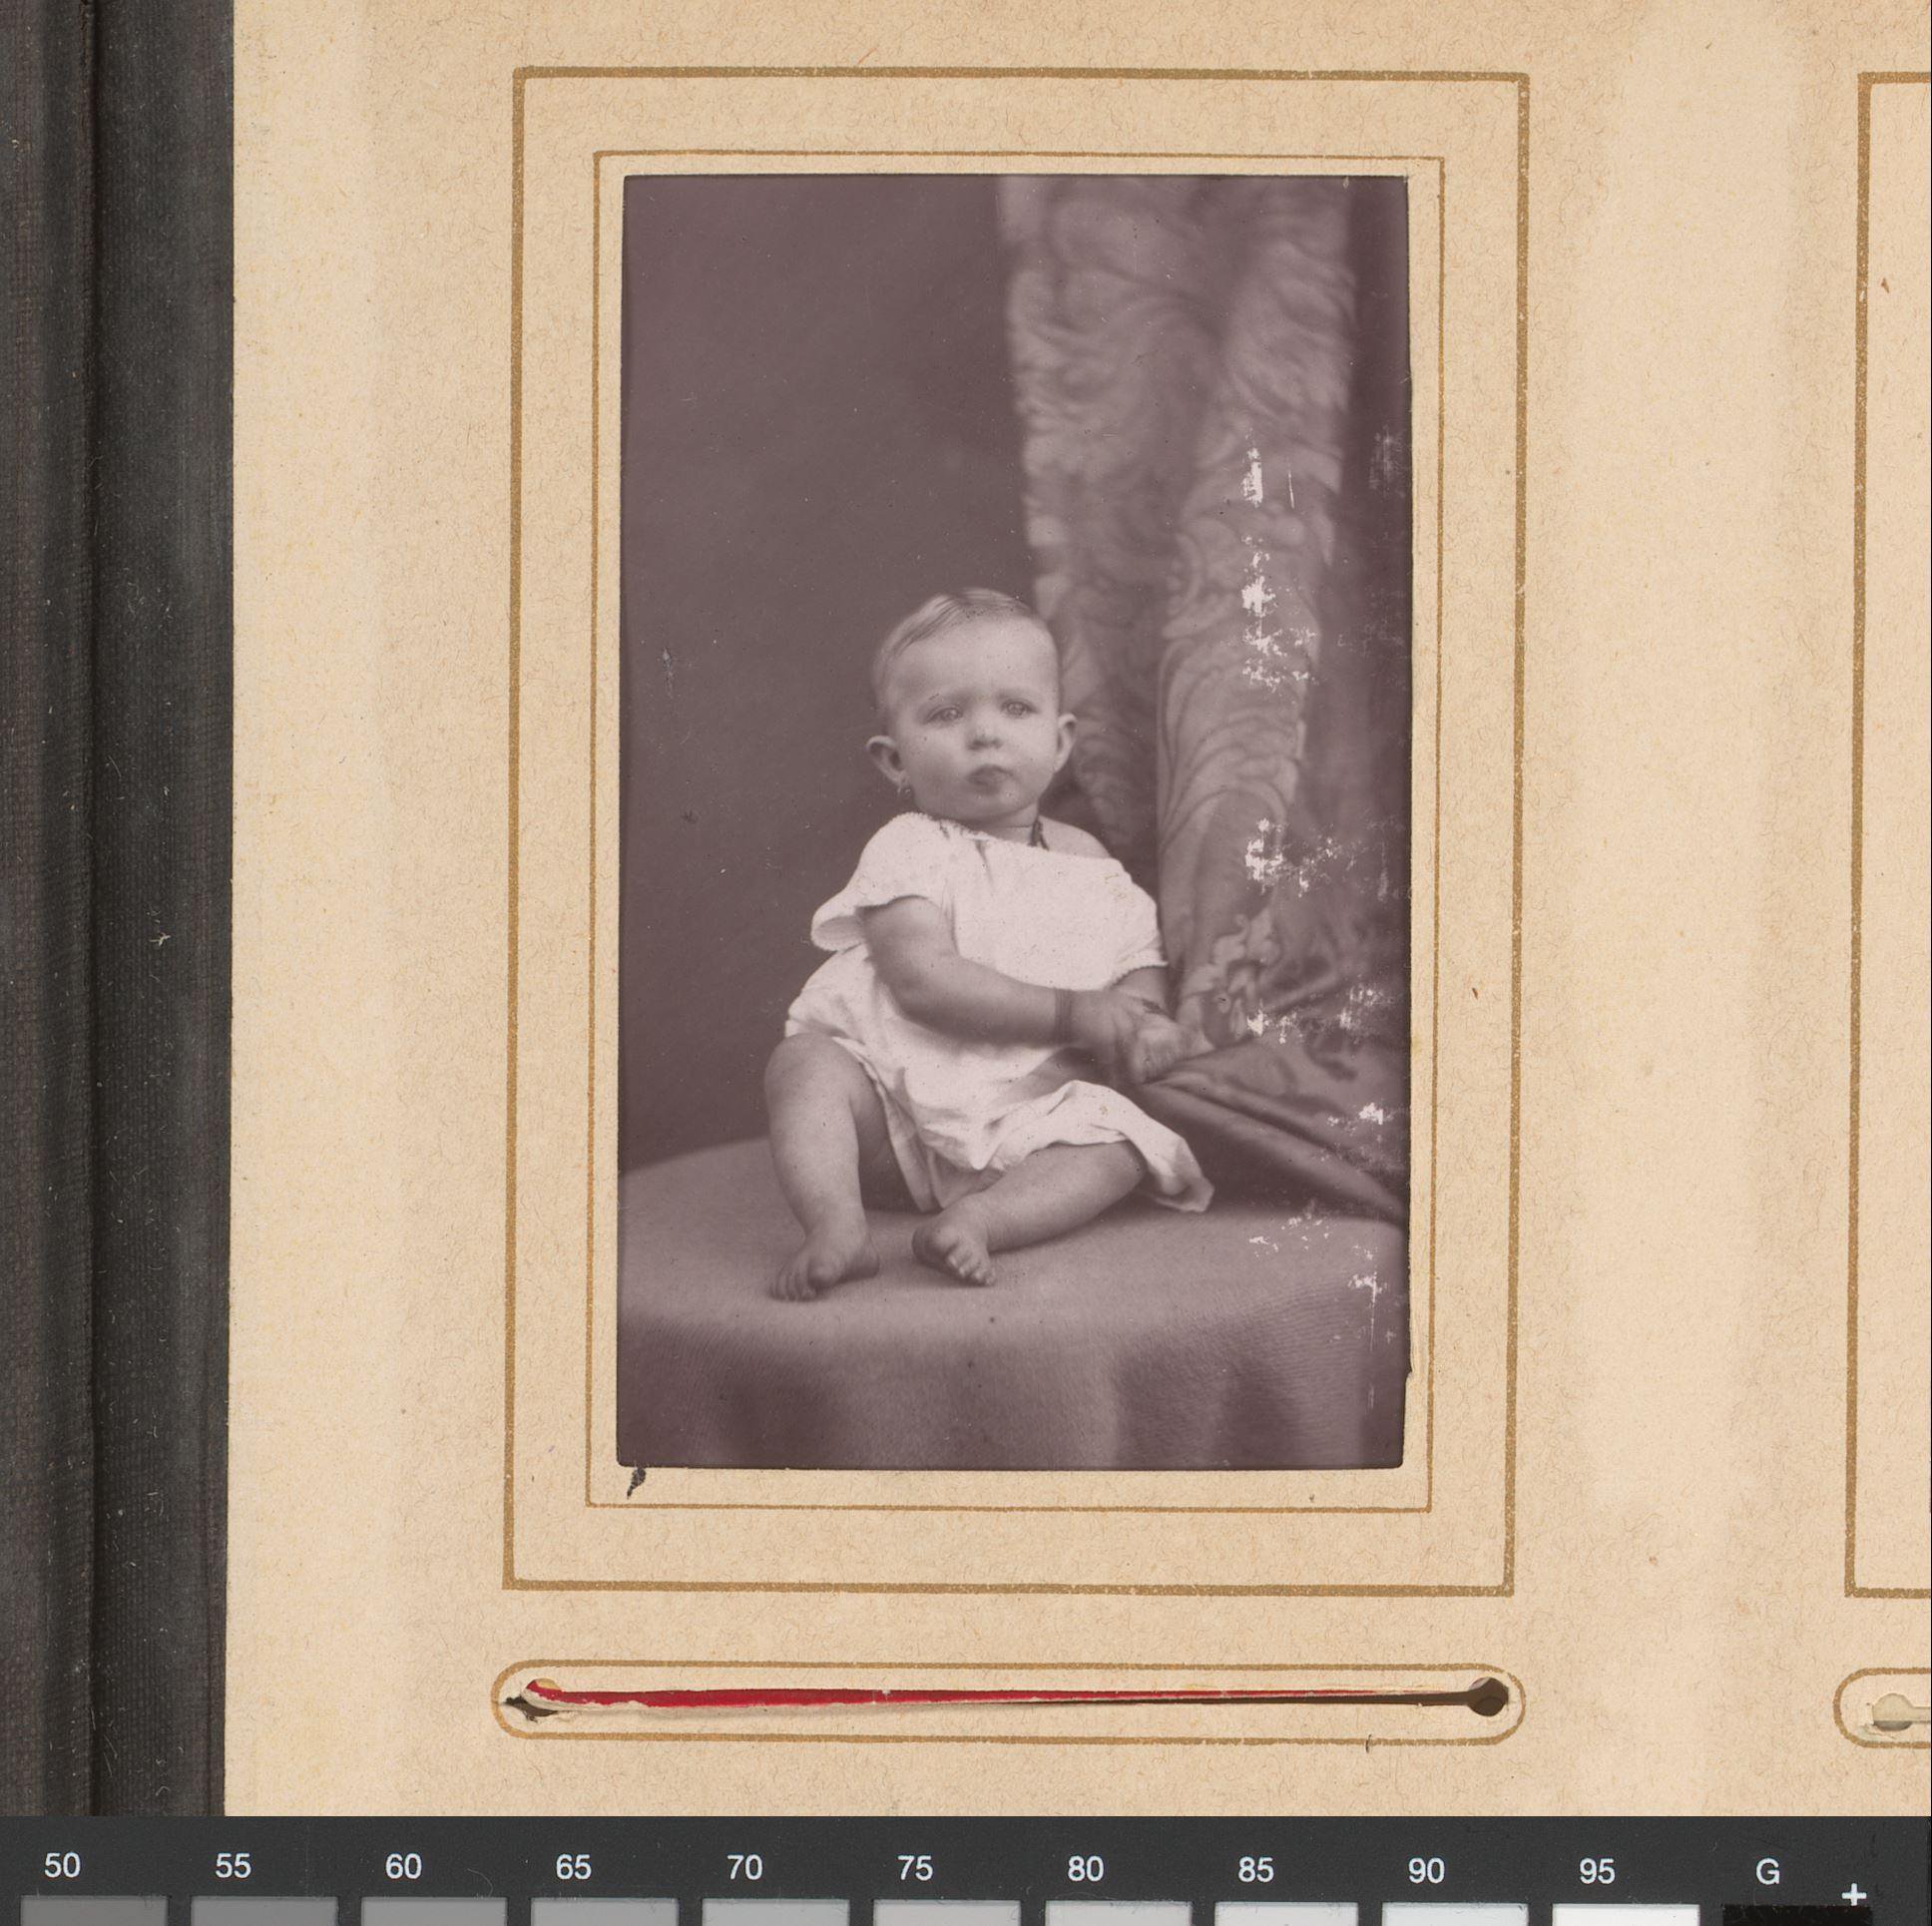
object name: carte de visite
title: Portret van een baby, aangeduid als Brigite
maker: charles emmanuel dhoy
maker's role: fotograaf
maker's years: 1823-1892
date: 1878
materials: cardboard, photographic support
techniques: collodion silver print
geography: ghent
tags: infant, baby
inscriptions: inscription: ‘Gand/ Charles d'Hoy/ Photographe/ Rue Courte du Jour 25/ près pont Madou/ Gand’, annotation: ‘Brigie/ 7 maanden 6 dagen/ 13 oct. 1878’